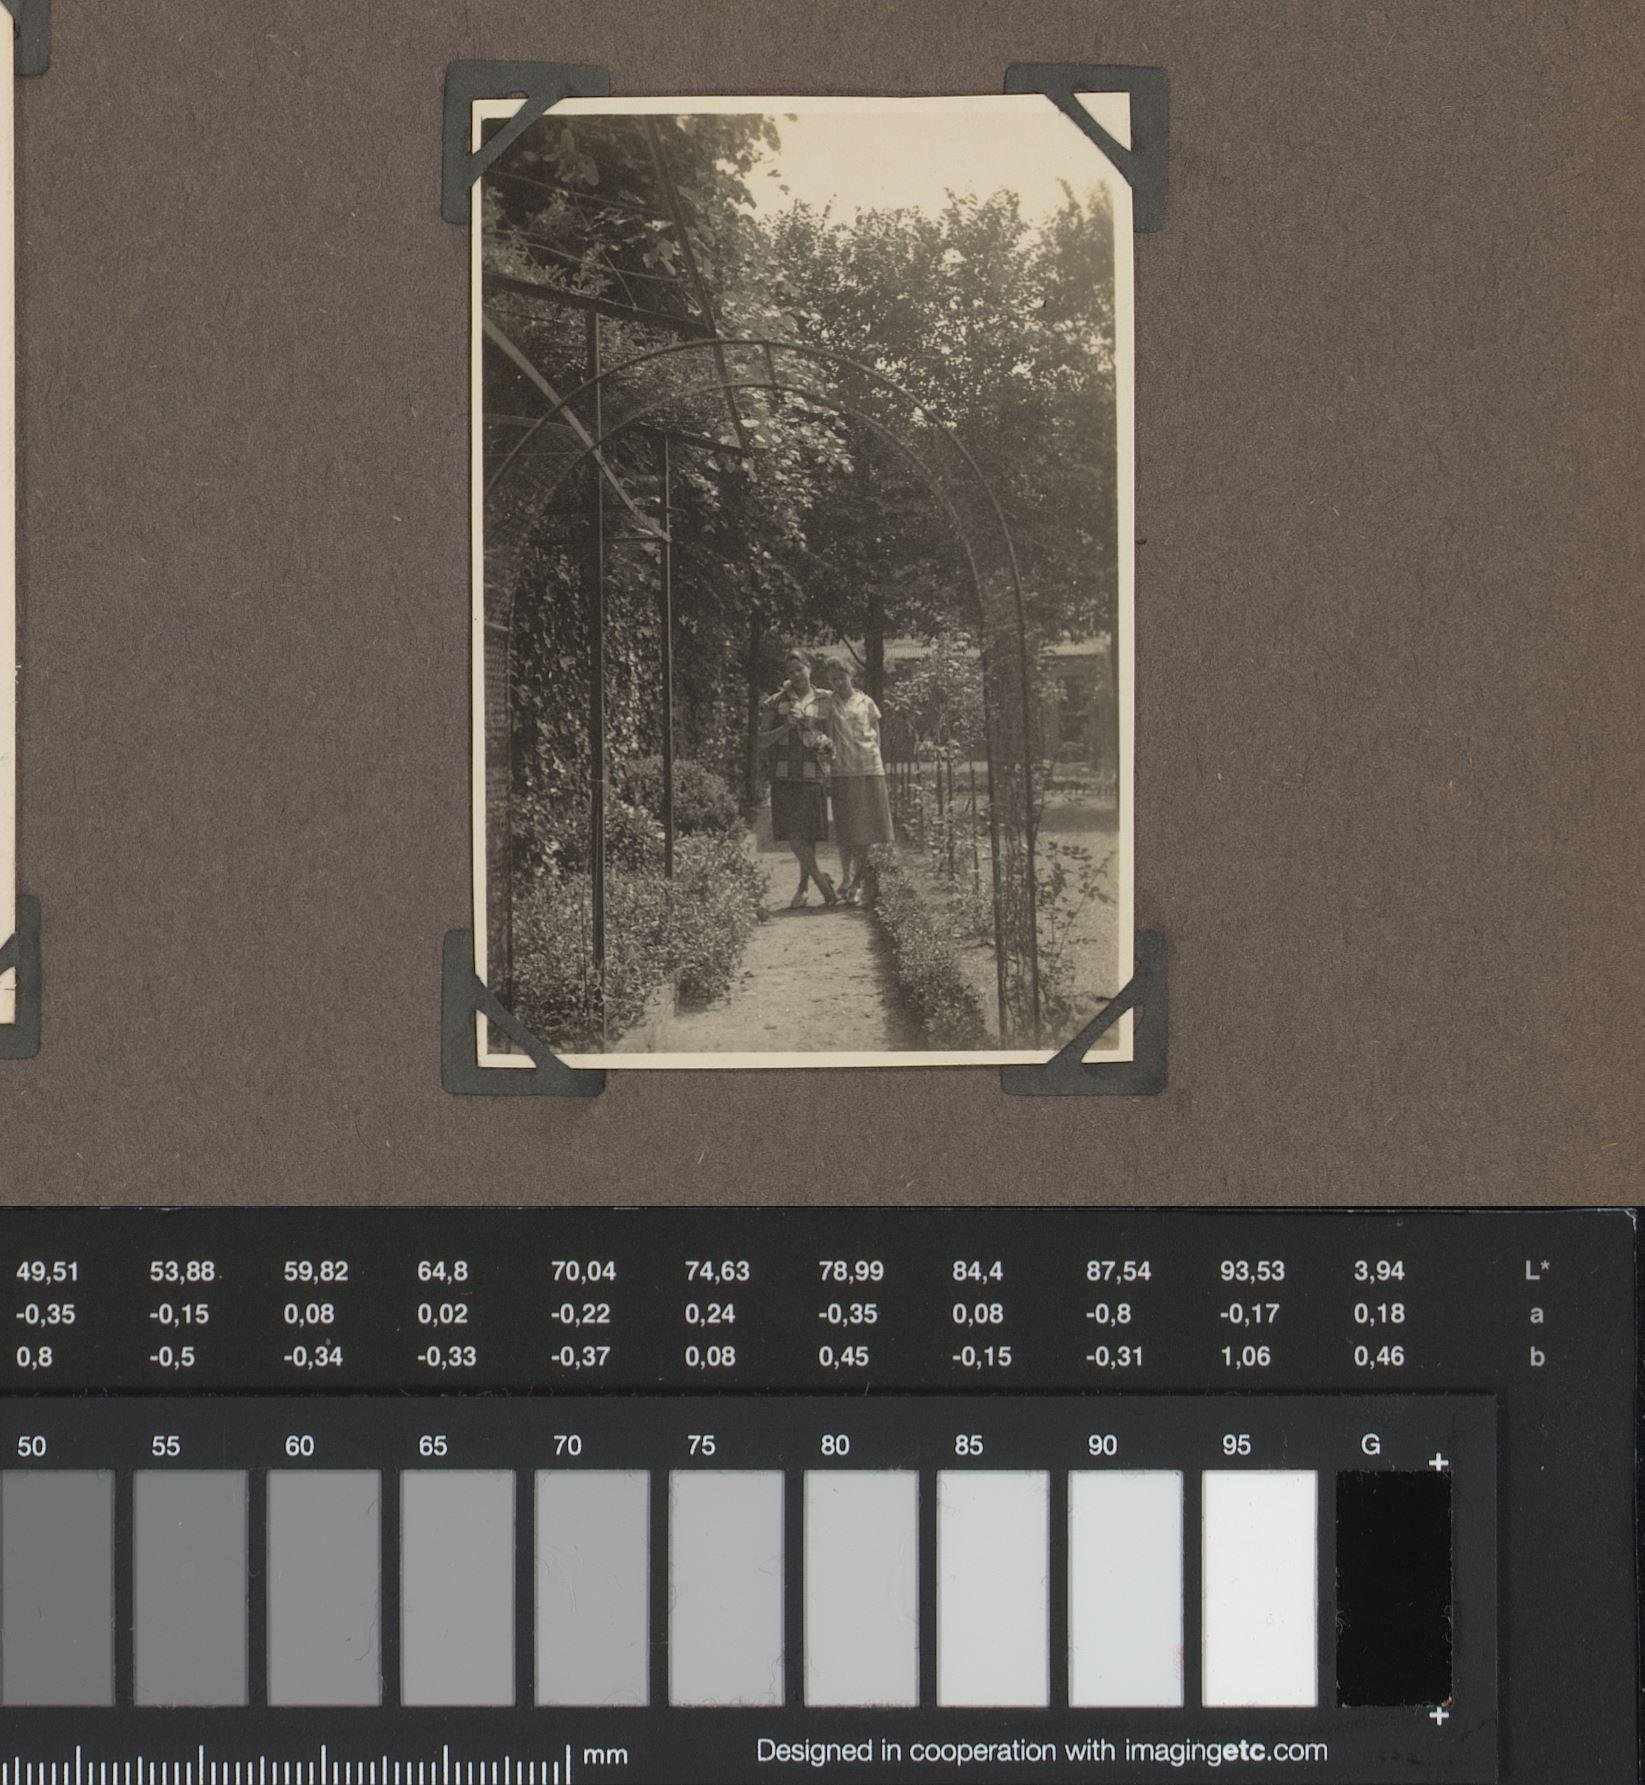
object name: photograph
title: Wilhelmina en Dootje van Zijll de Jong in een tuin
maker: Anonymous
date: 1930-1935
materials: paper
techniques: gelatin silver print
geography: netherlands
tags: amsterdam, the hague, wilhelmina van zijll de jong, garden, sisters (second degree family relationships), netherlands